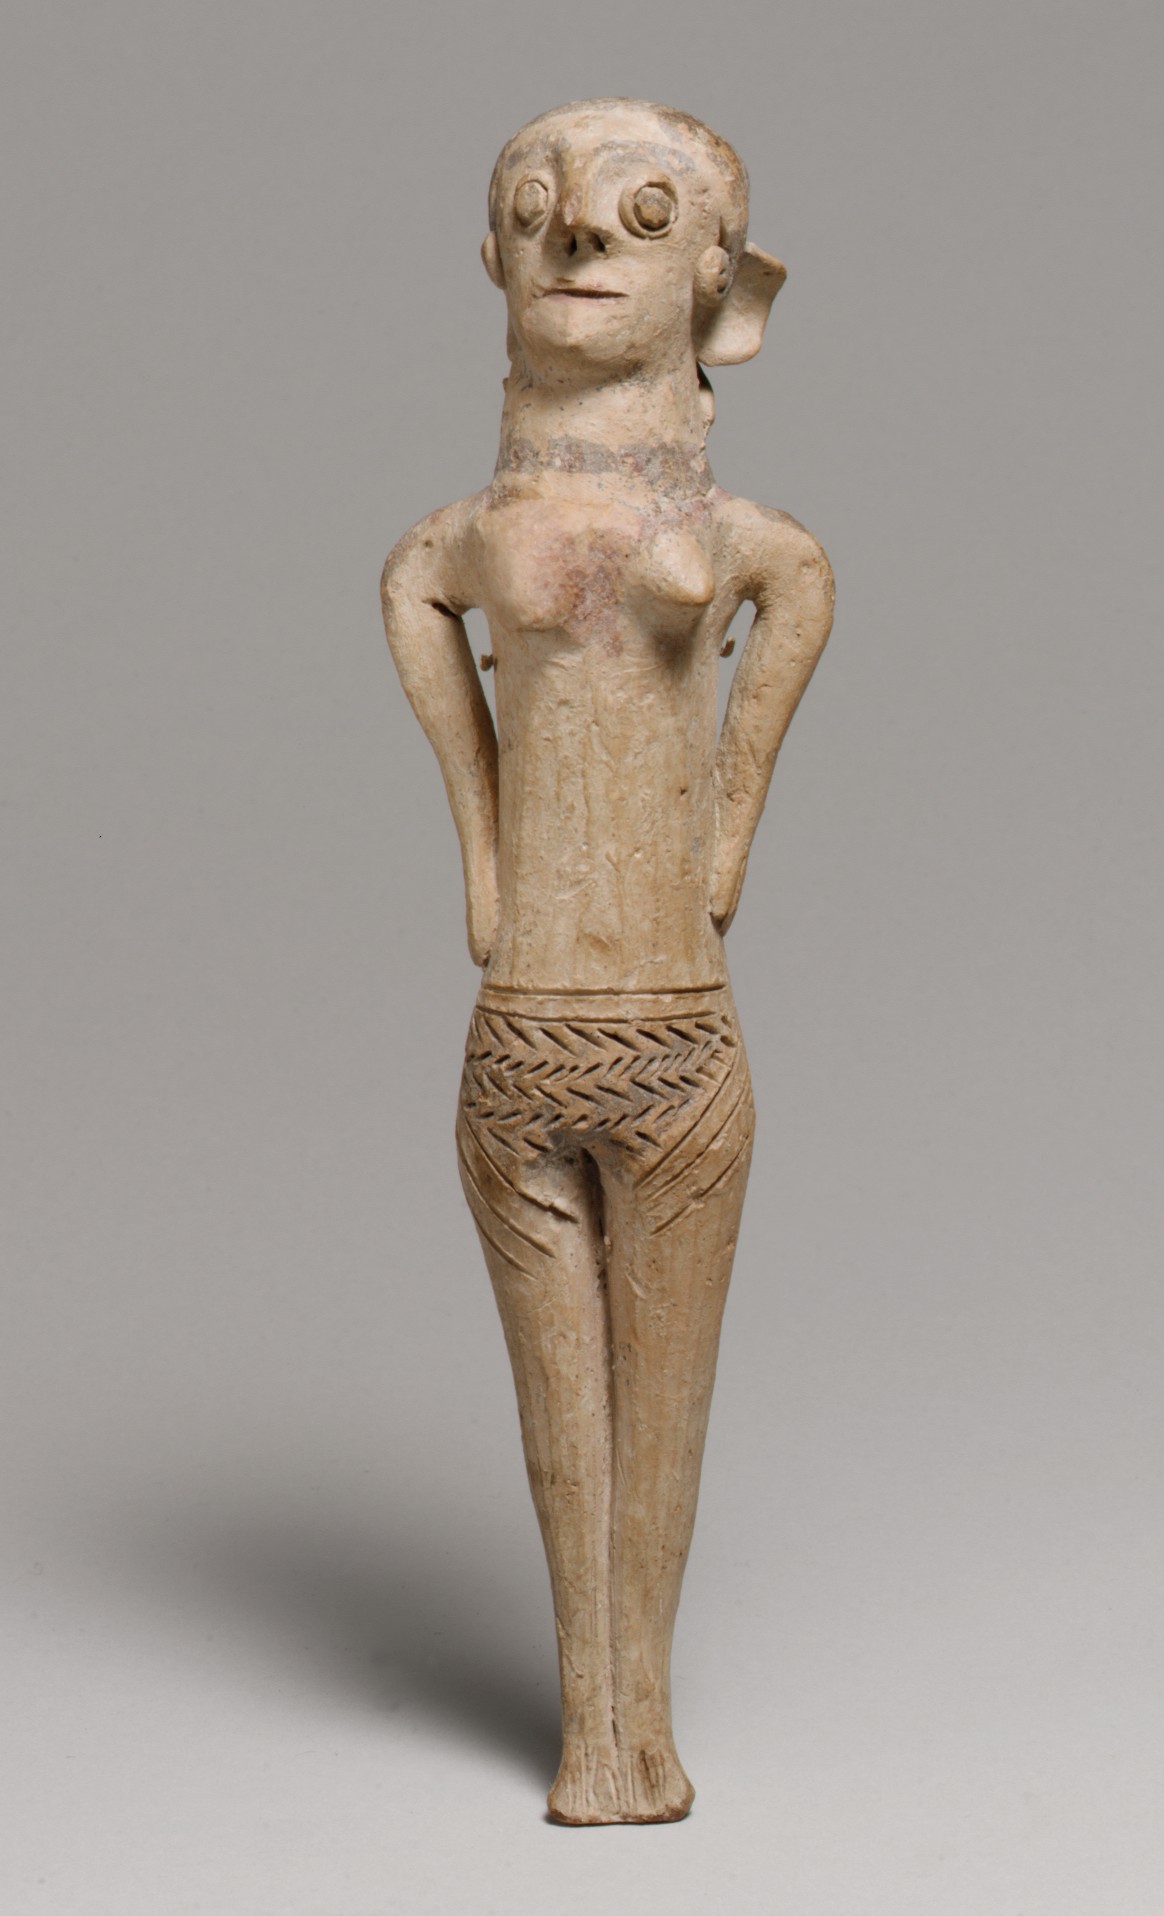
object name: statuette of a woman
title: Terracotta statuette of a woman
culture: cypriot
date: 1450-1200 BCE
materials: terracotta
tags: women